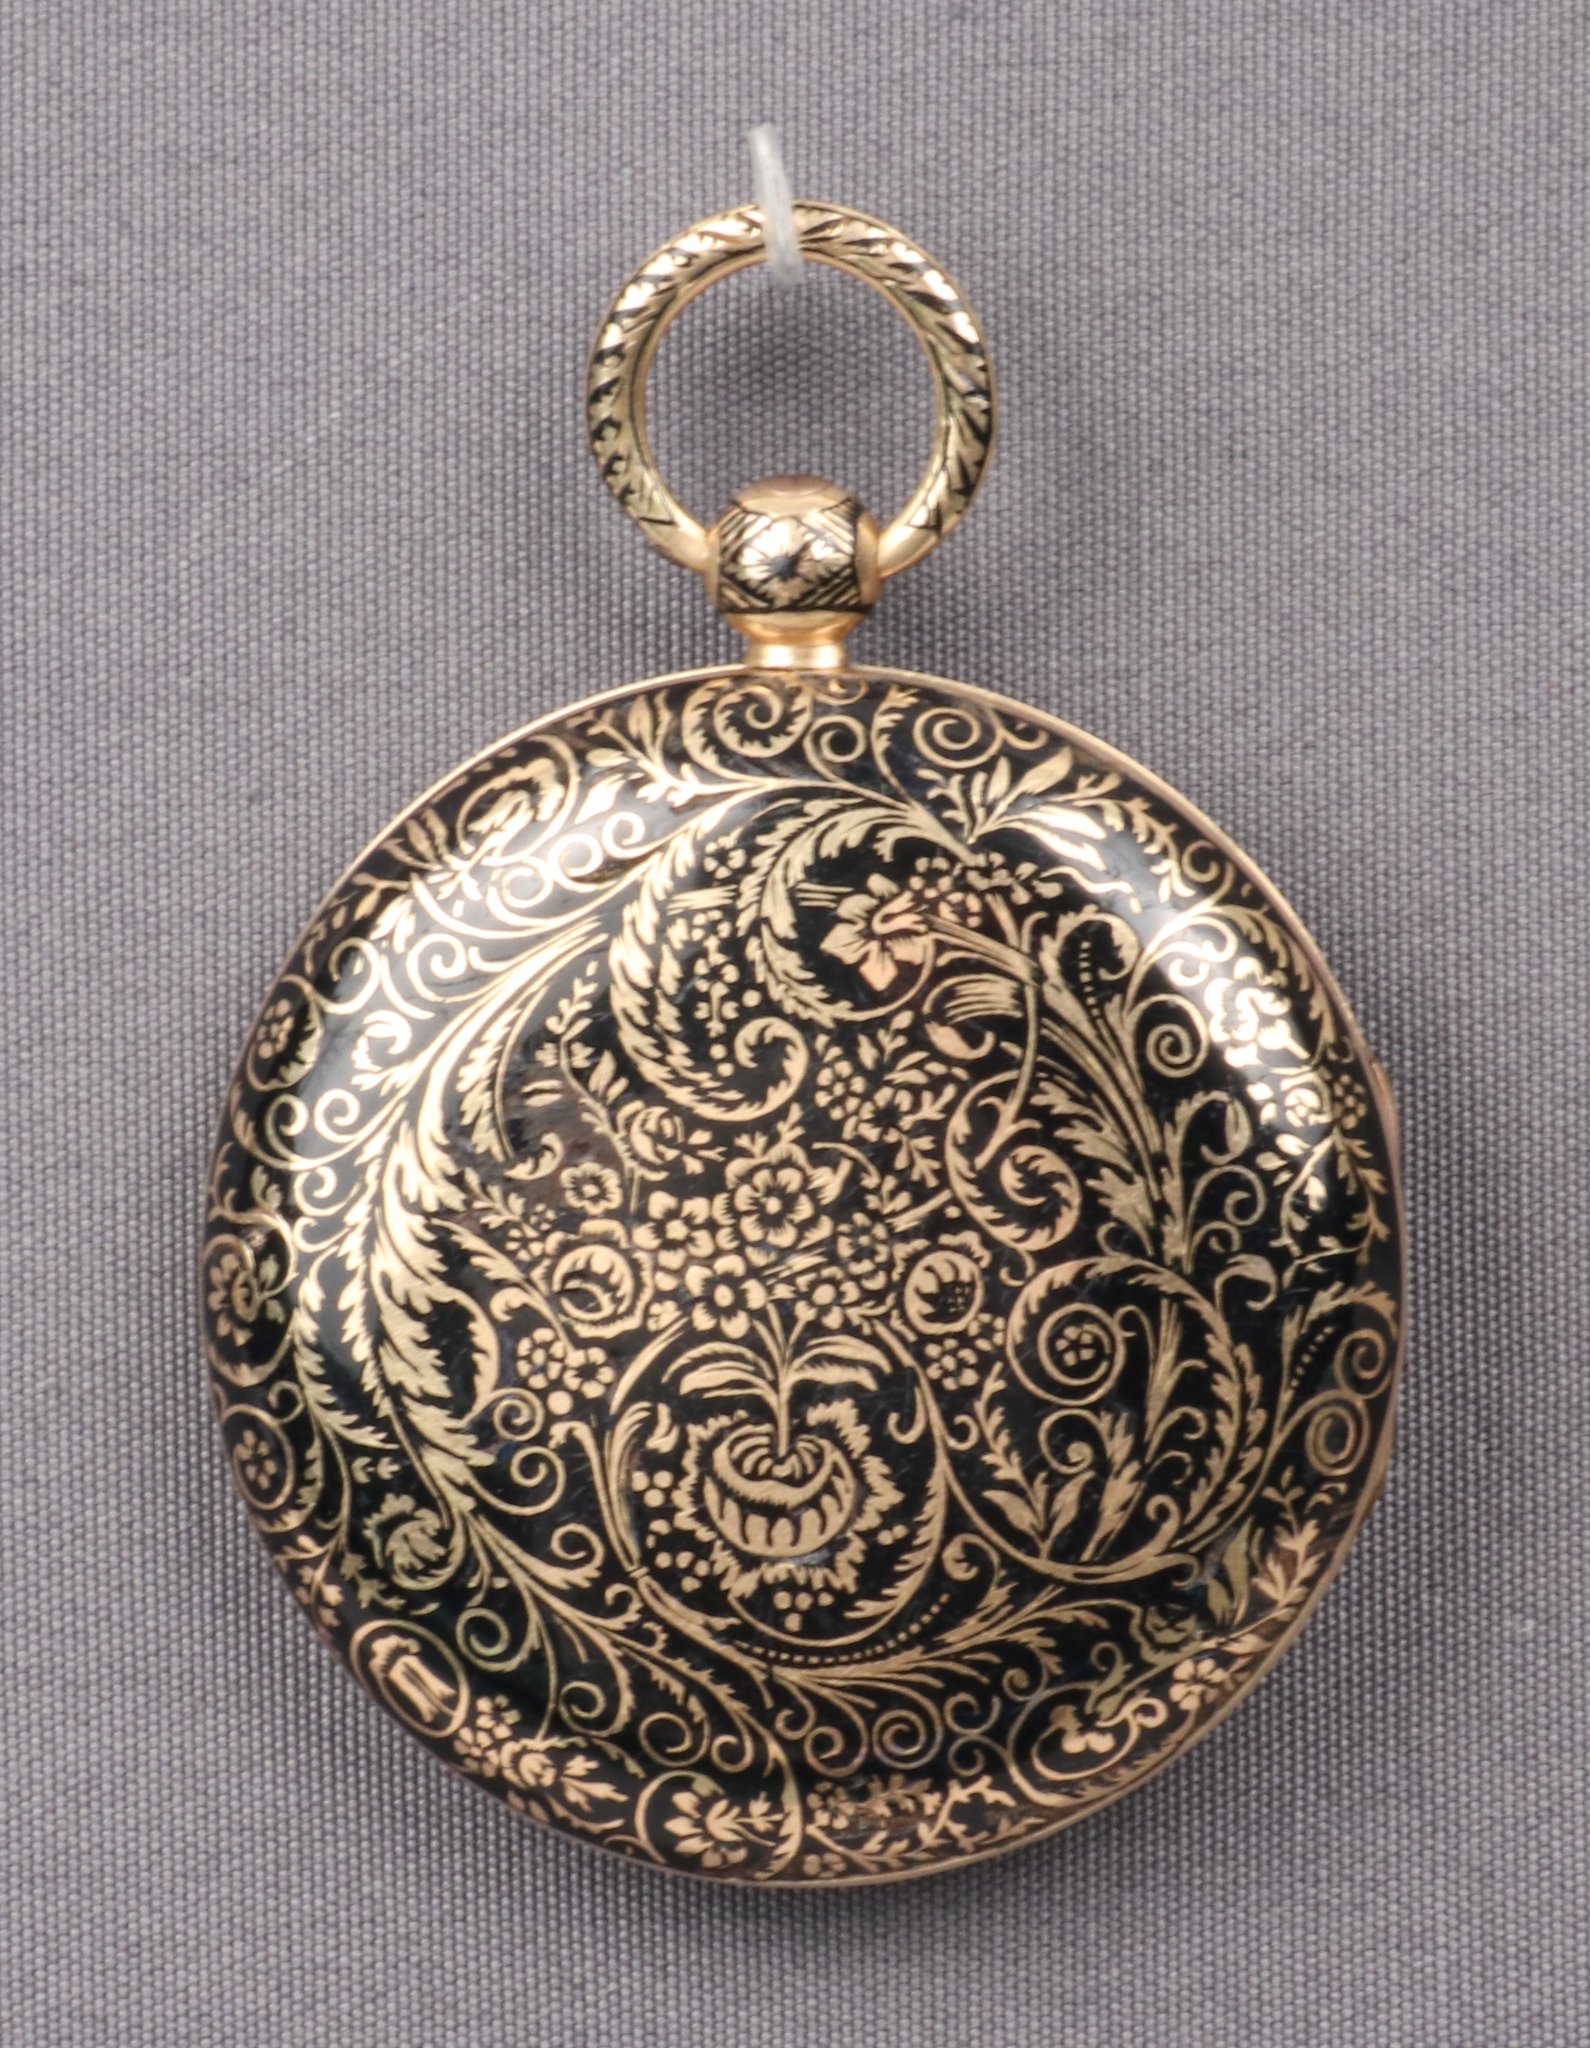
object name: watch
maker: firm of bautte et moynier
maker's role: maker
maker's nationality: swiss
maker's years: 1826-1831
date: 1826-1831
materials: enamel, gold, silver, steel